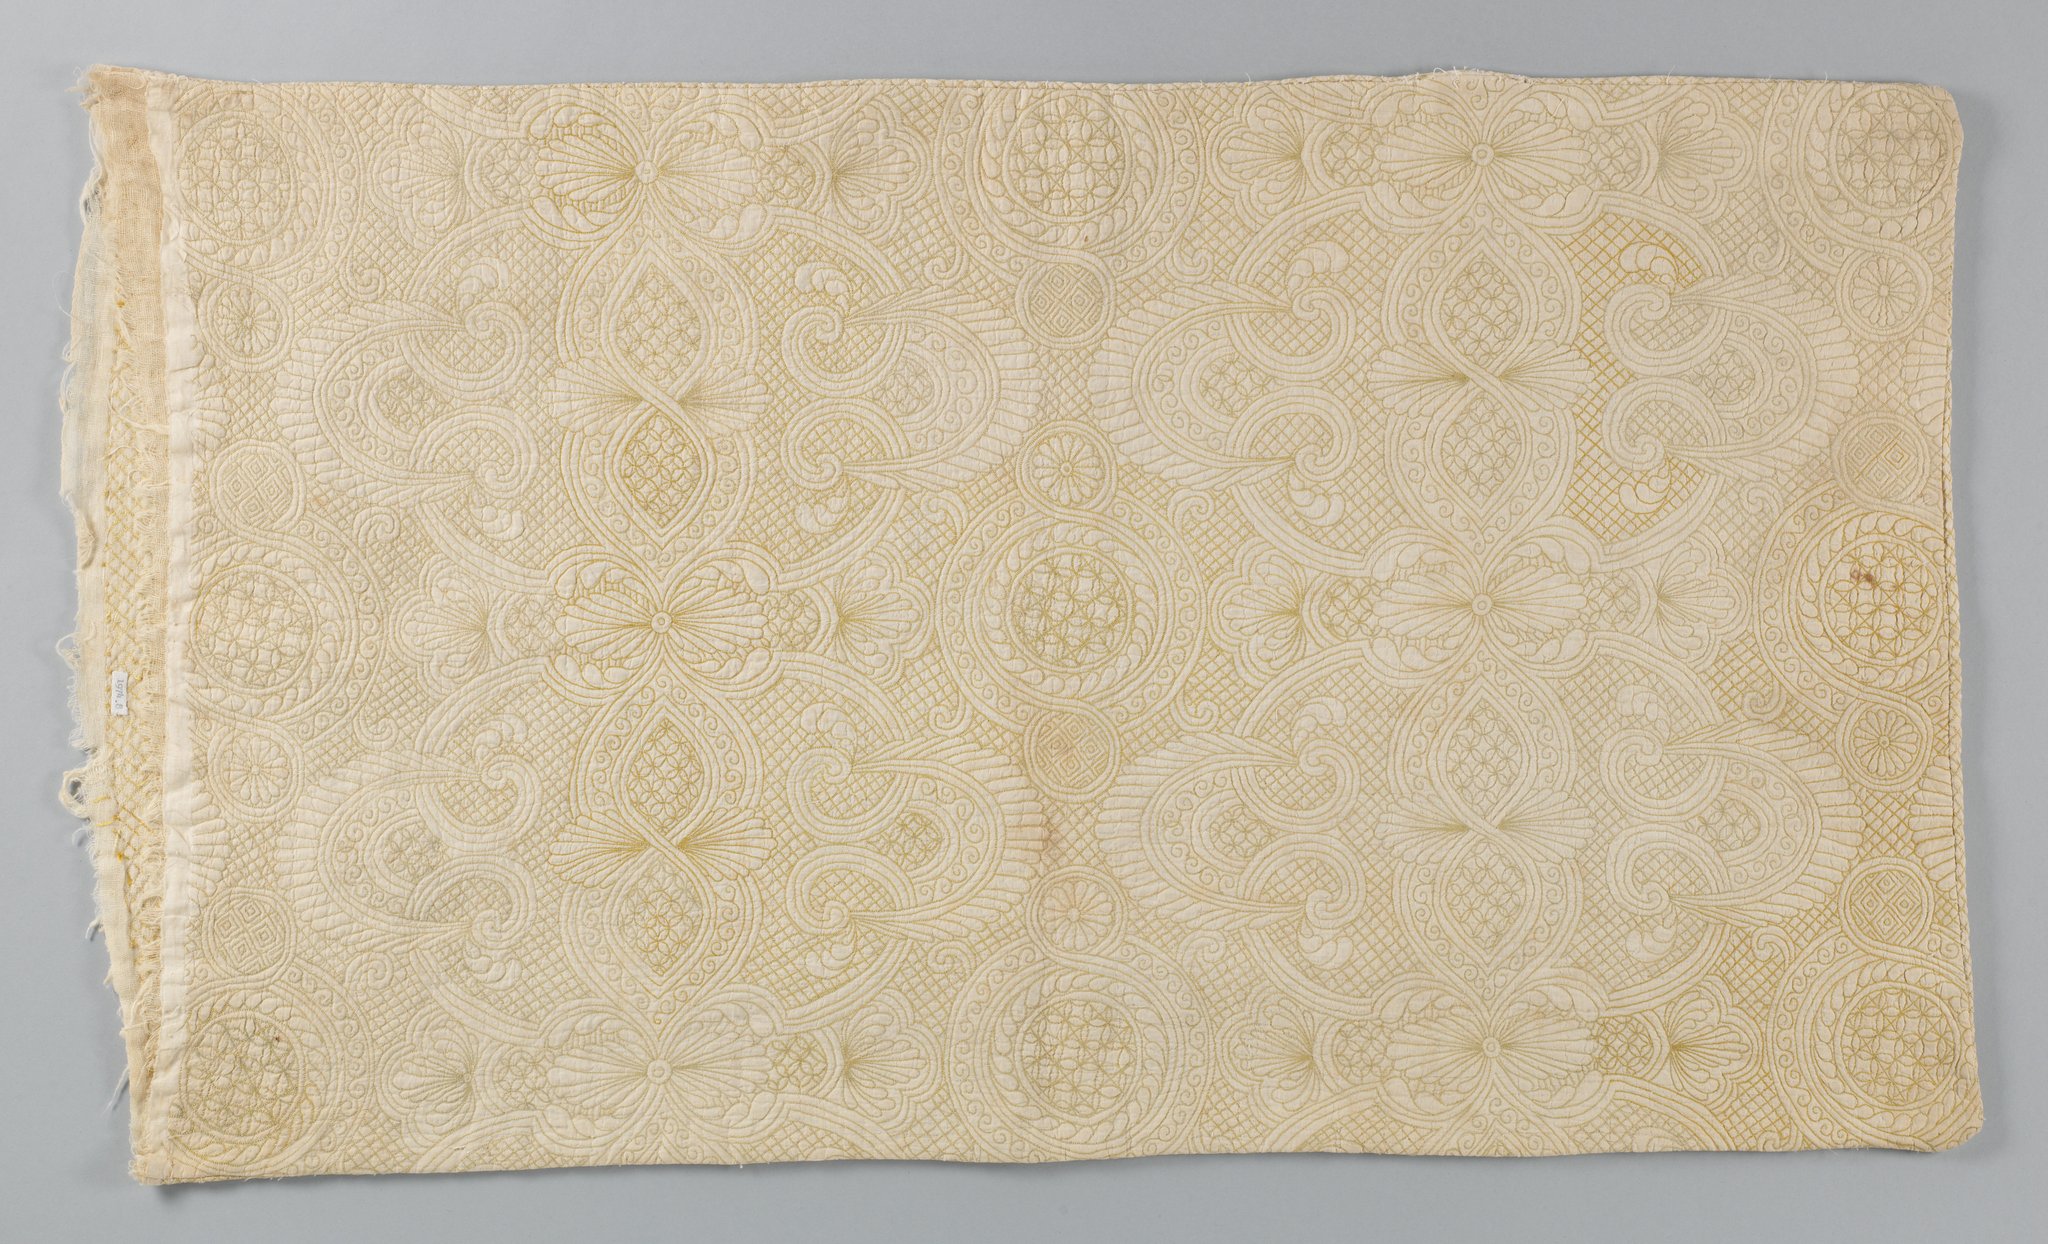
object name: pillowcase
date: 1700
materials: linen, silk